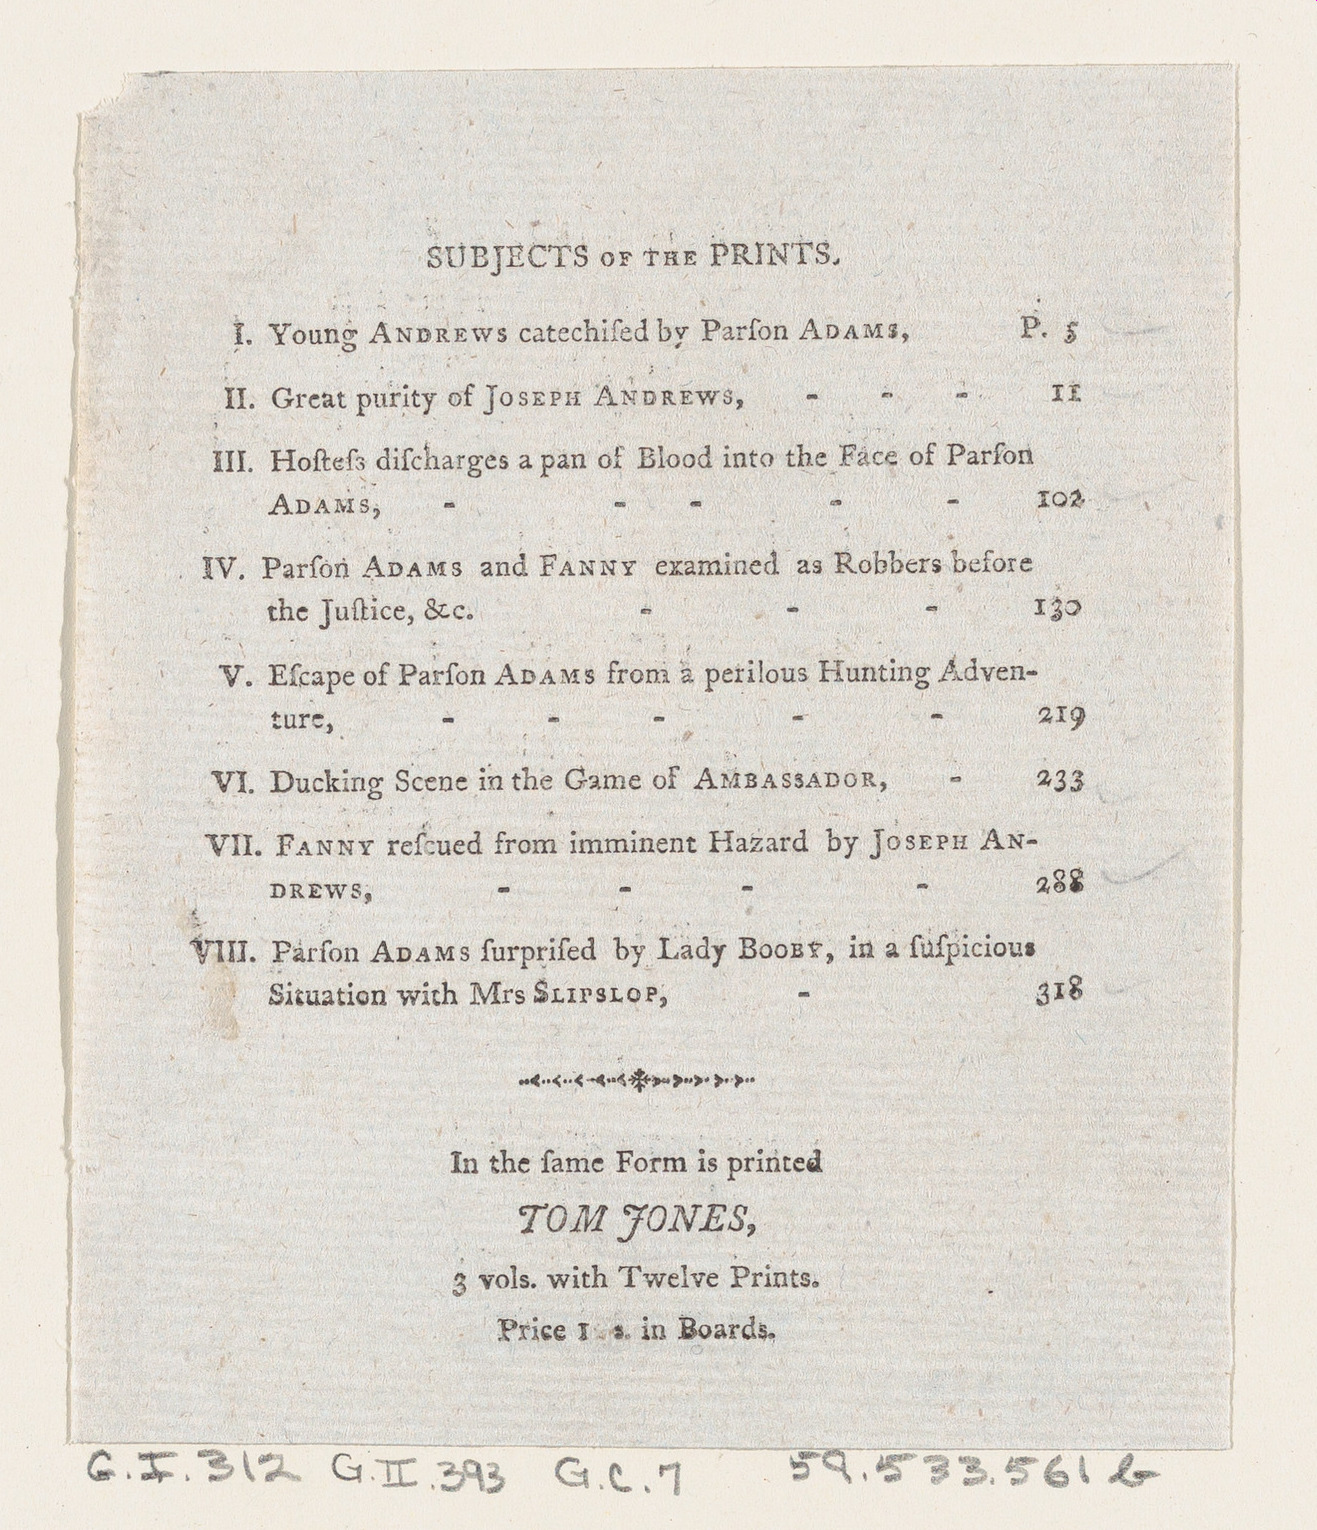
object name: print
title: Table of Contents: "The Adventures of Joseph Andrews, and his friend Mr. Abraham Adams"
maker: thomas rowlandson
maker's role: artist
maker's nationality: british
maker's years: 1757-1827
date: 1792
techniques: letterpress